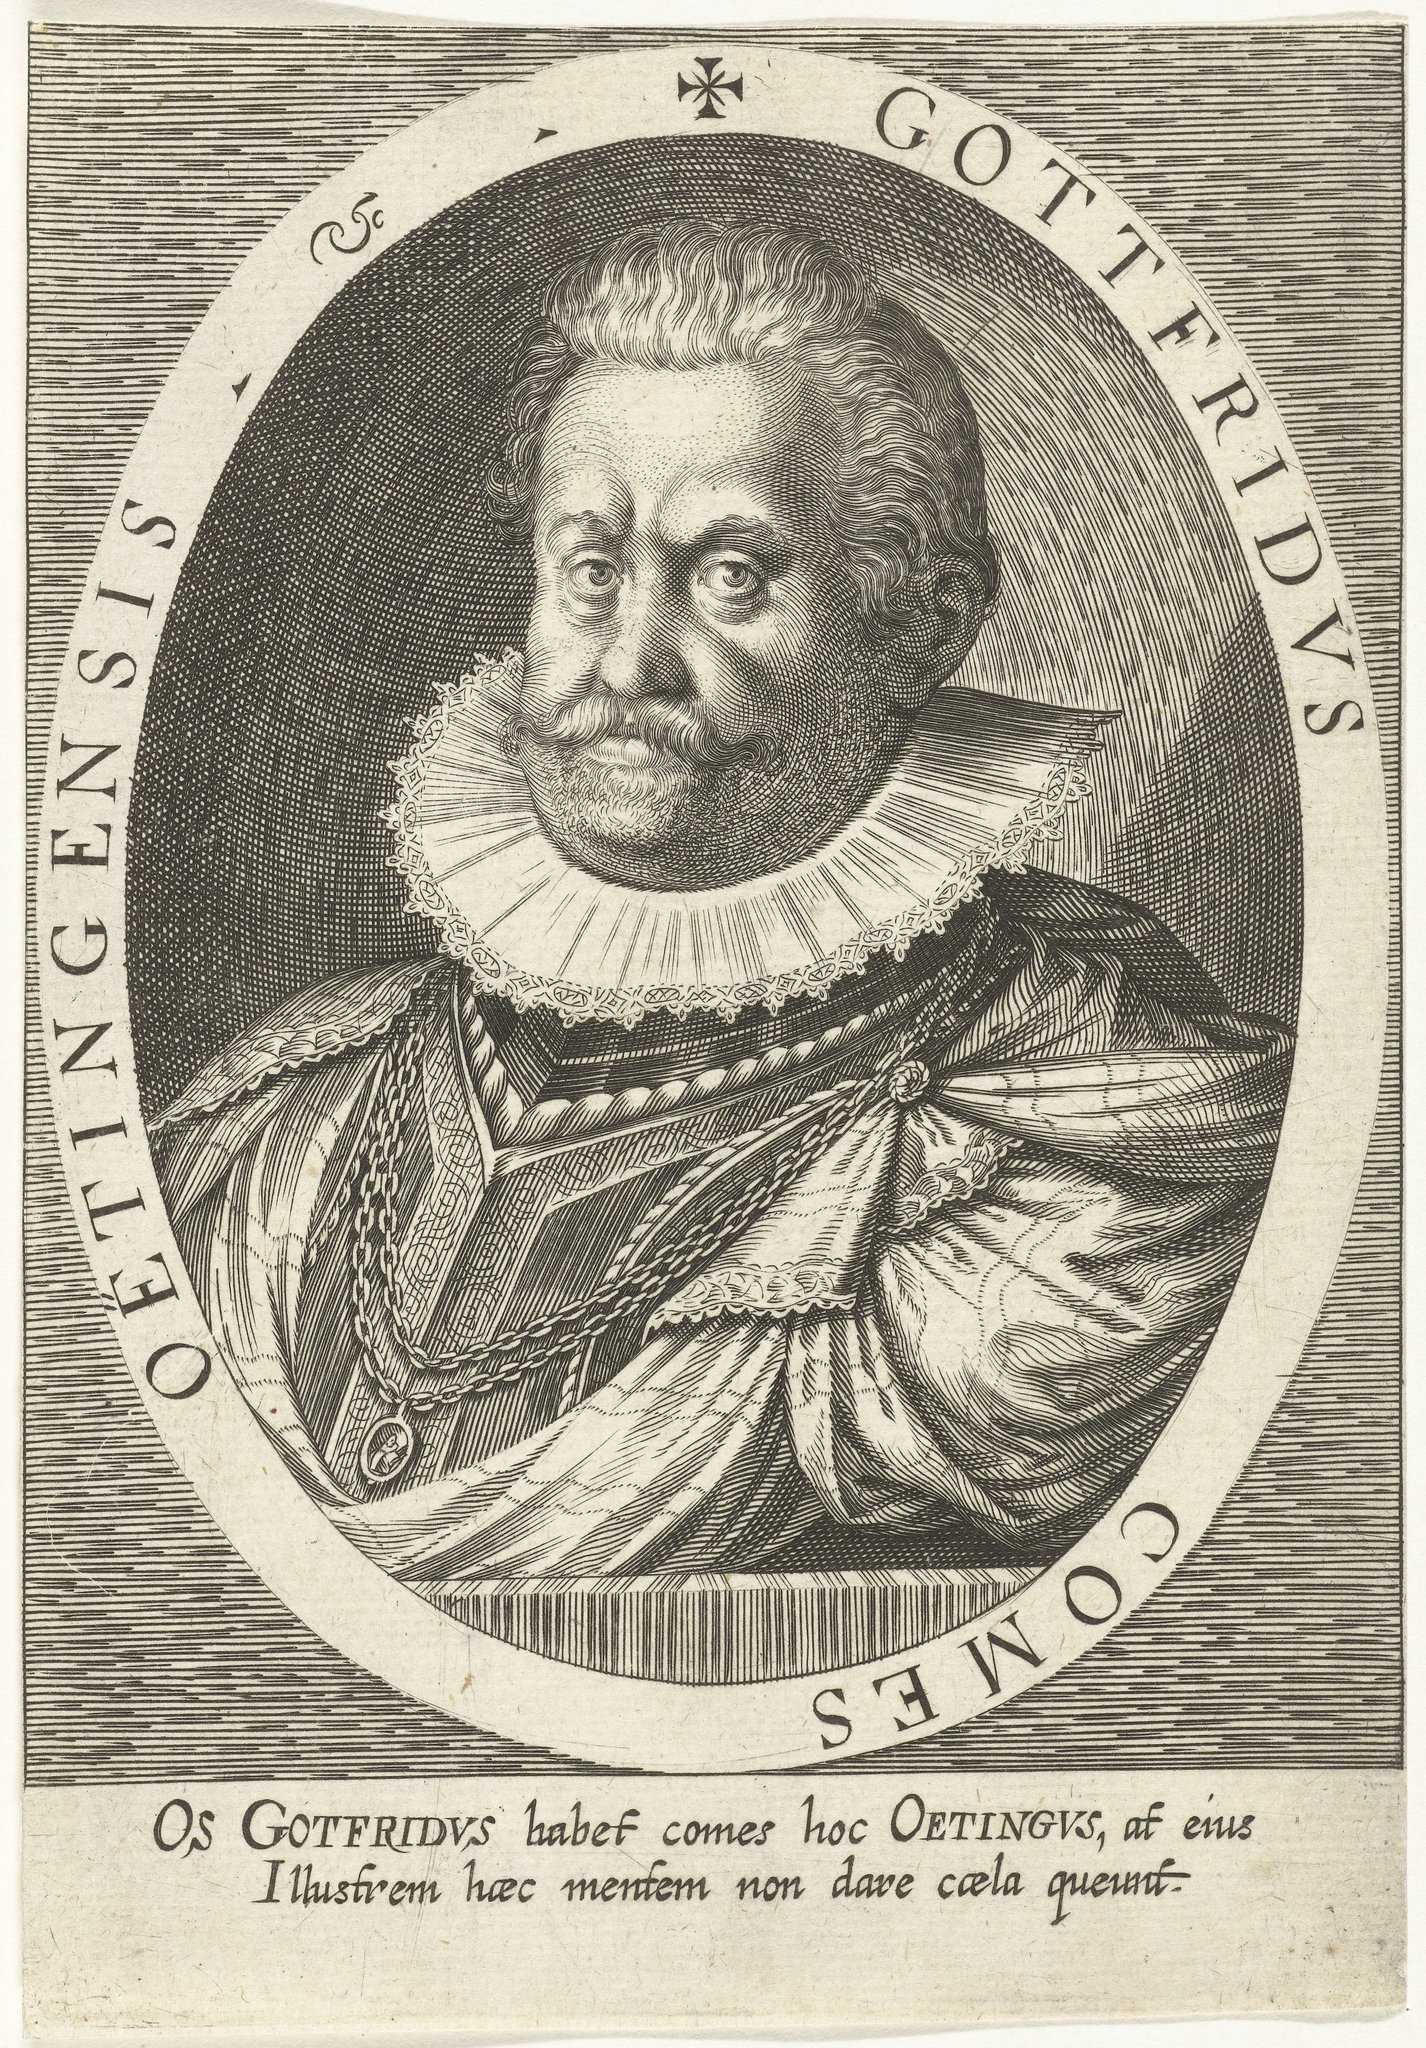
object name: print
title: Atrium Heroicum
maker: dominicus custos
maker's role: print maker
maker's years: 1560-1615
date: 1600-1604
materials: paper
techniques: engraving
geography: augsburg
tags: gottfried graaf van oettingen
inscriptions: collector's mark: Lugt 2228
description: Illustratie uit: D. Custos en M. Henning. Atrium heroicum Caesarum, regum aliorq. summatum ac procerum qui intra proximum seculum vixere, aut hodie supersunt, imaginib. Deel 1-4. Augsburg: D. Custos, 1600-1604.